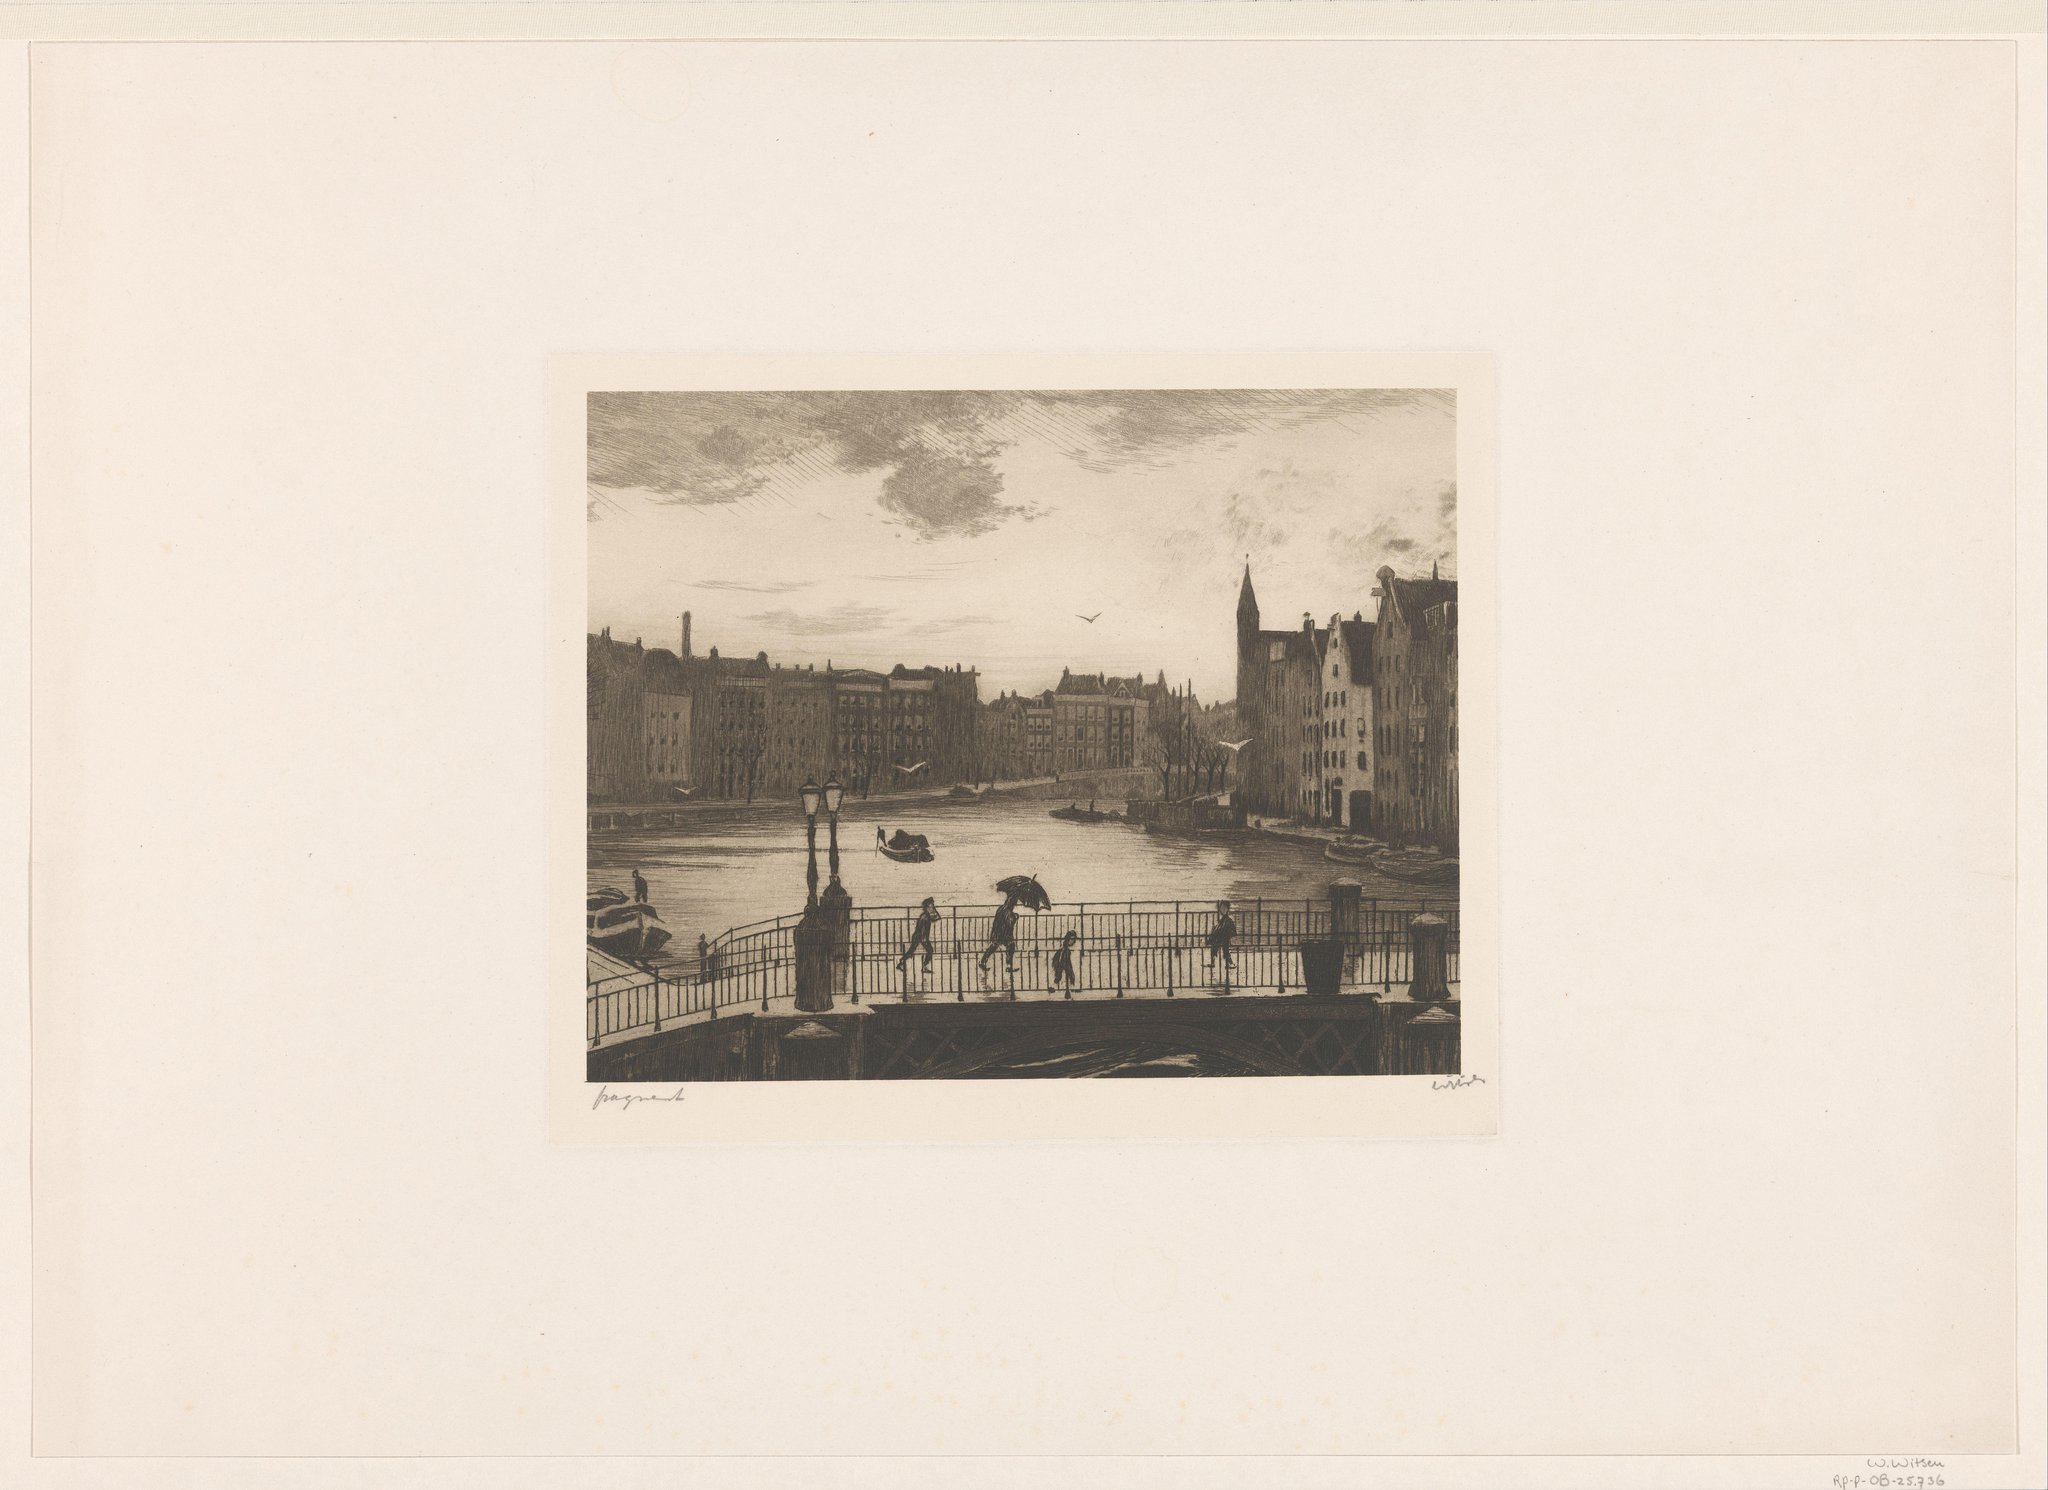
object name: print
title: Gezicht op de Binnen-Amstel in Amsterdam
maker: Anonymous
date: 1906-1907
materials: paper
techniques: aquatint, etching, intaglio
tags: city-view in general; 'veduta', bridge in city across river, canal, etc. - ii - ideal city, city dwellers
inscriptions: inscription: ‘fragment’, inscription: ‘fragment’, collector's mark: Lugt 2228